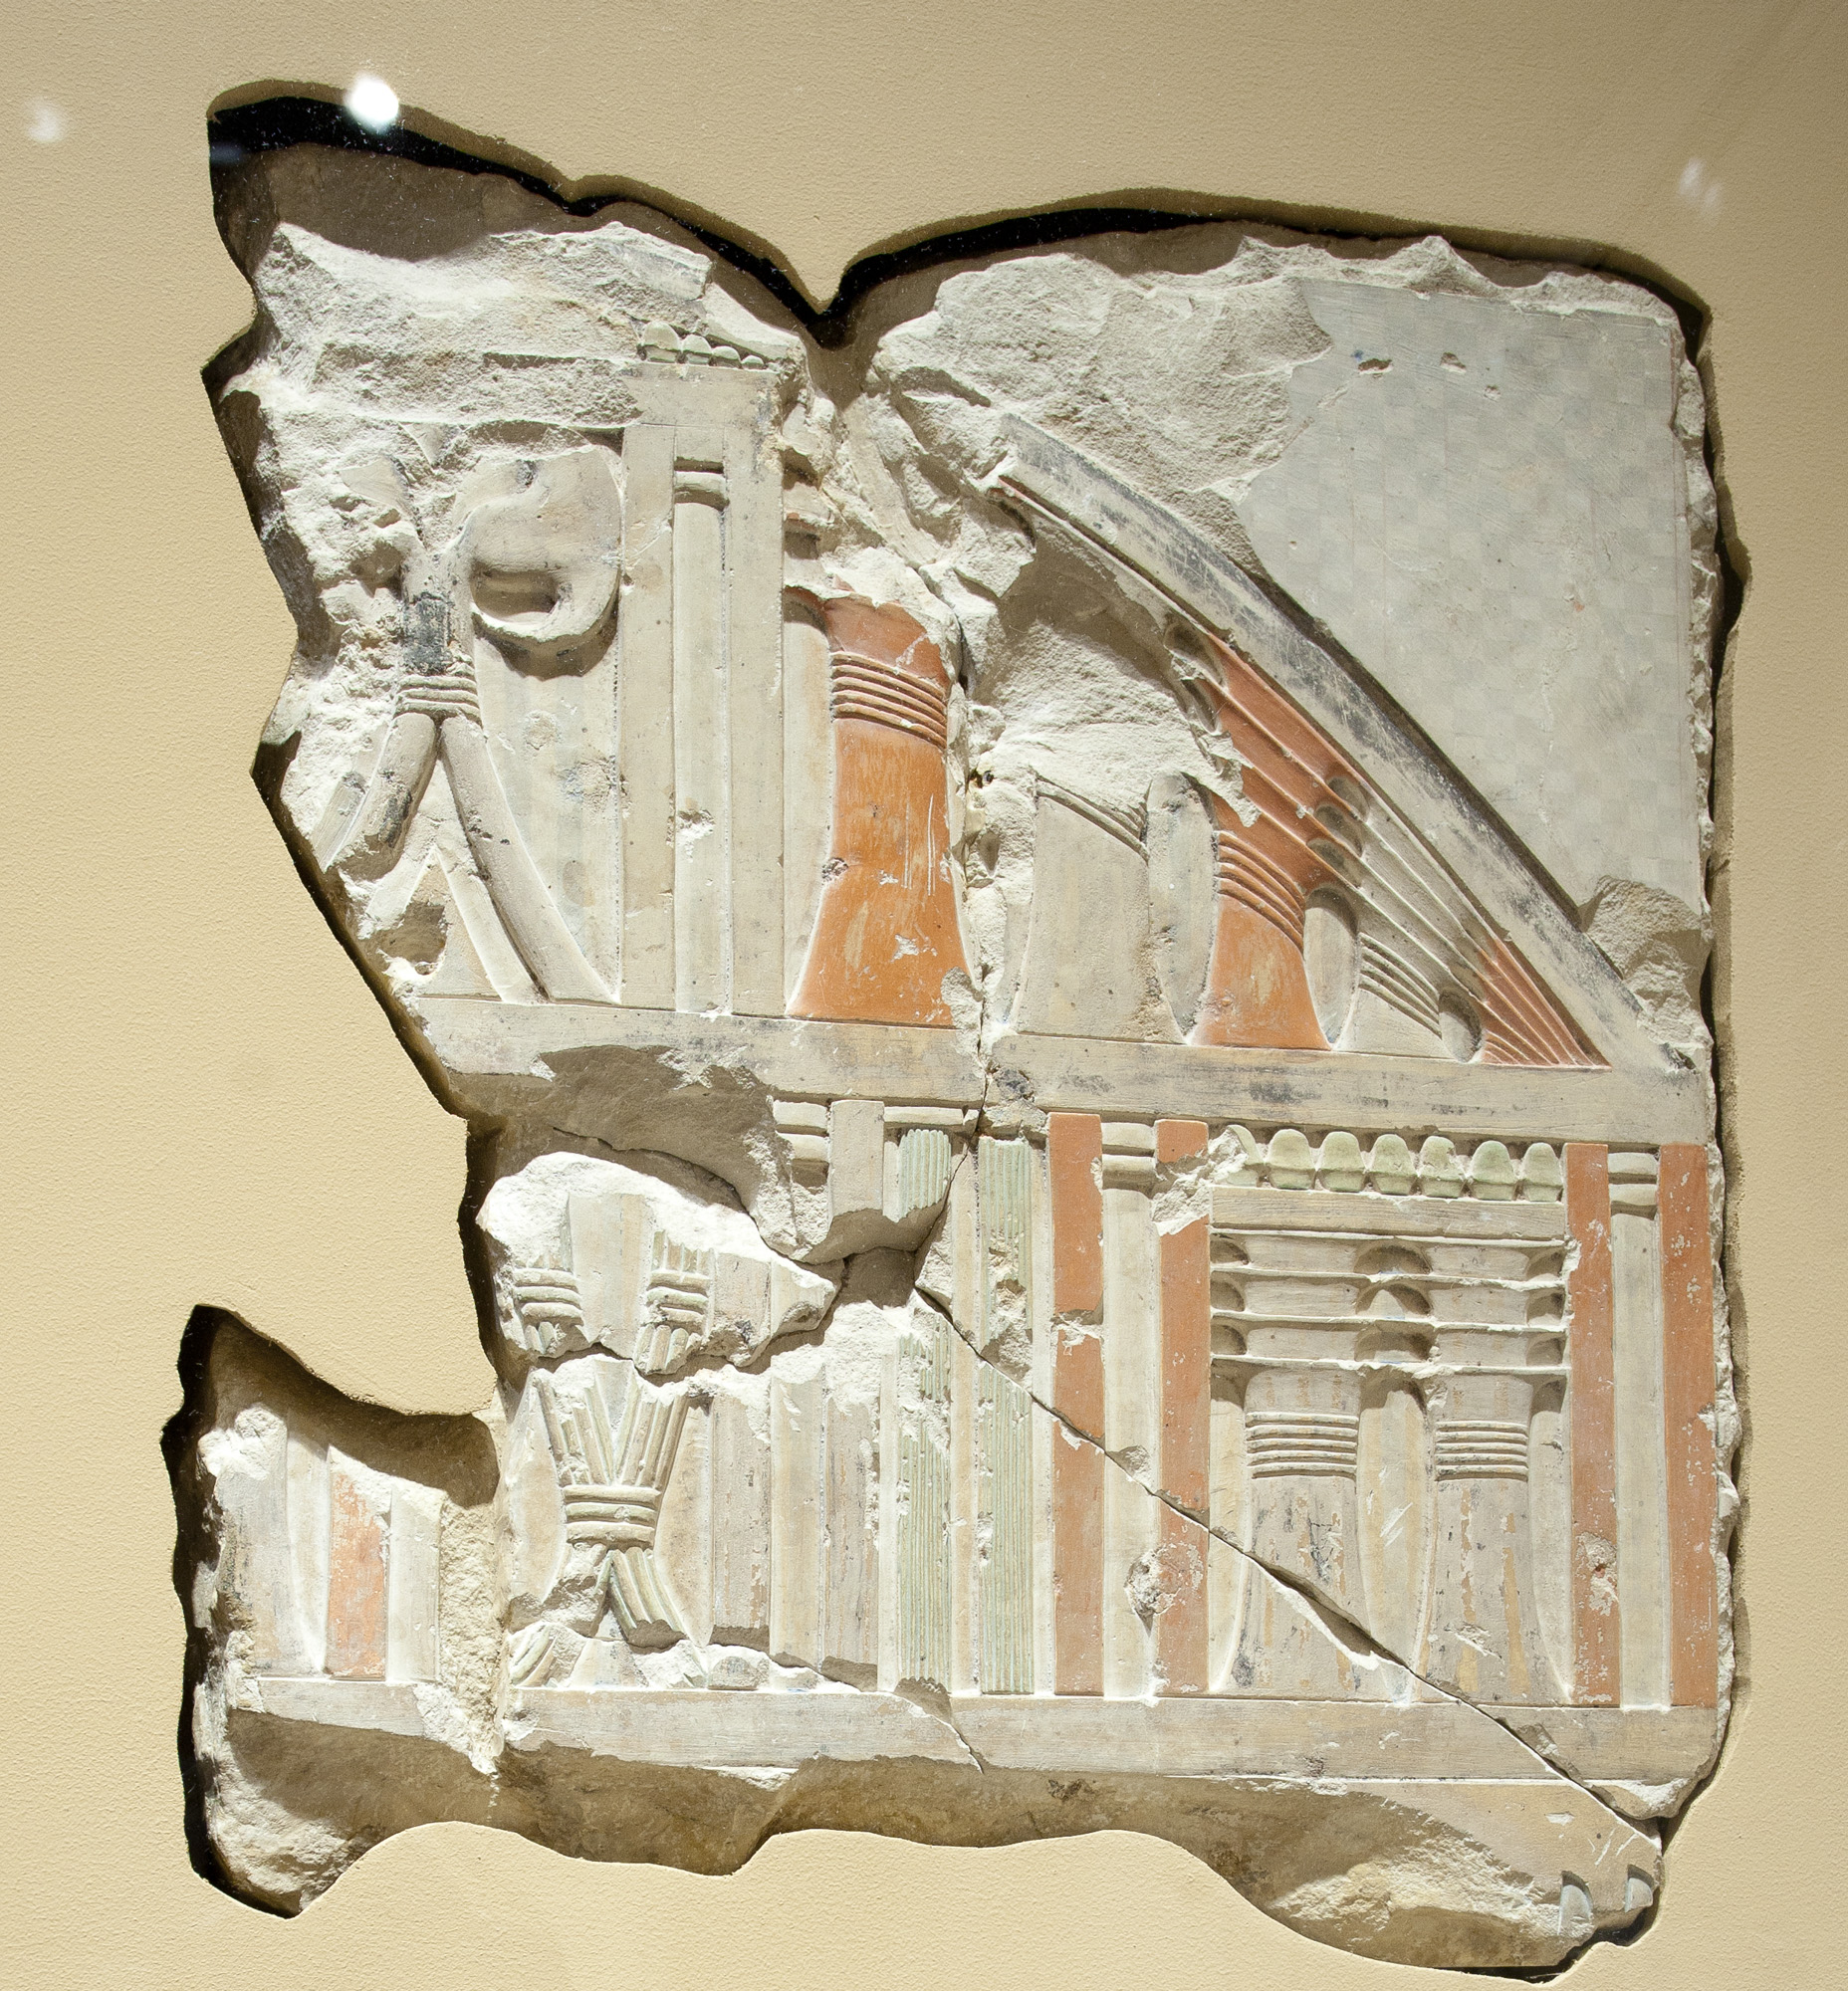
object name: relief, tomb of khety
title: Part of an elaborate roof or canopy - see 26.3.354-2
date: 2051-2000 BCE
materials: limestone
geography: egypt